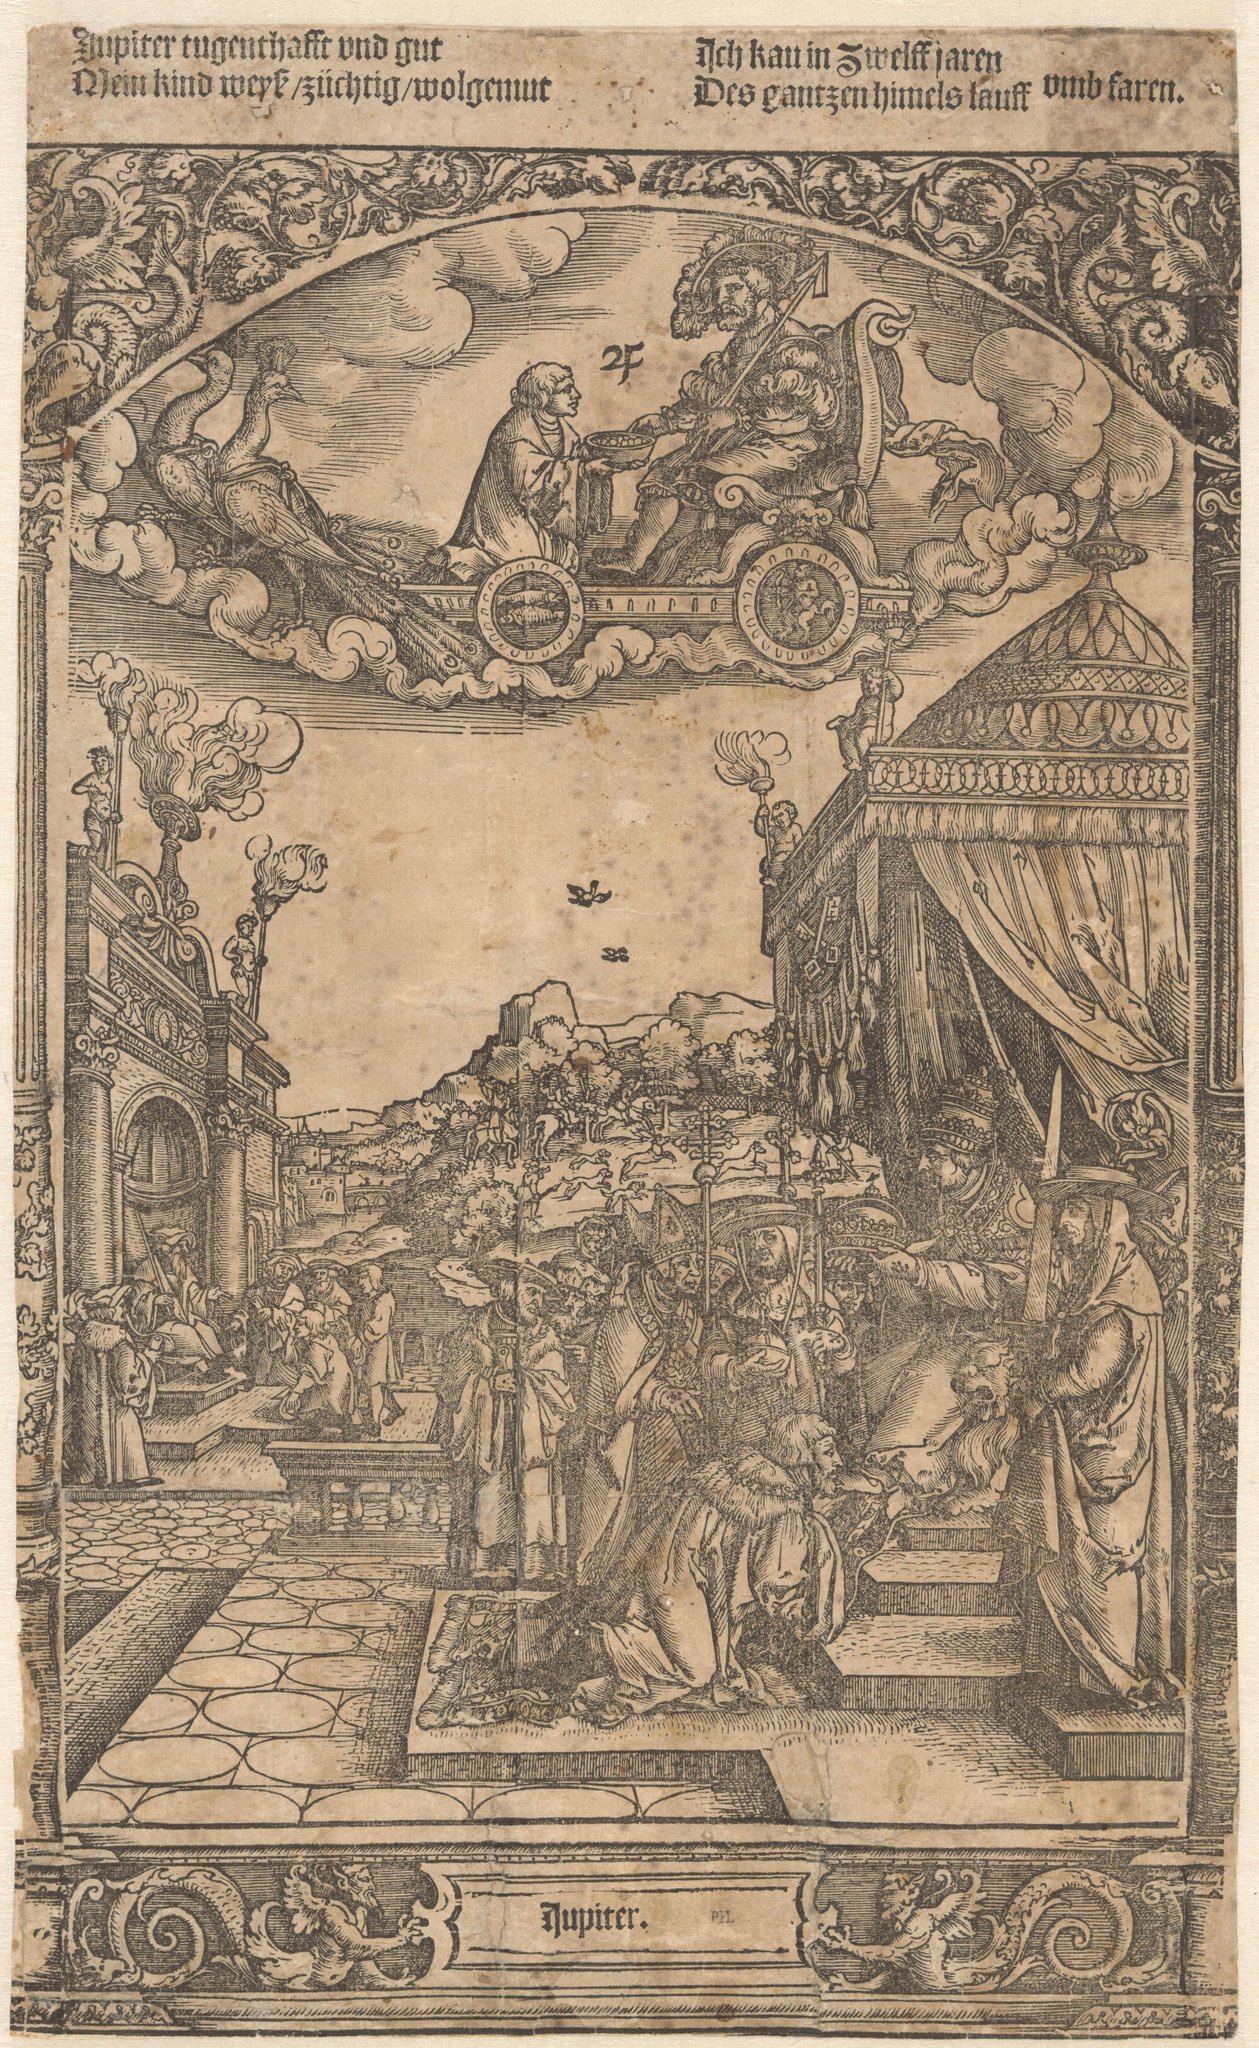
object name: print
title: Jupiter en zijn planeetkinderen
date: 1531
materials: paper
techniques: woodcut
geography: germany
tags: jupiter and his children ('planetenkinder'), jupiter and his children ('planetenkinder') ~ pisces and sagittarius, pisces (zodiacal sign of february), sagittarius (zodiacal sign of november)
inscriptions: collector's mark: Lugt 2228, collector's mark: Lugt 2760, collector's mark: Lugt 2090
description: Jupiter rijdt in zijn triomfwagen aan de hemel, getrokken door twee pauwen. Op de wagen de tekens van de dierenriem Vissen en Boogschutter. De mensen op aarde zijn wereldlijke of kerkelijke machthebbers. Een keizer wordt gekroond door de paus, die is omringd door kardinalen en bisschoppen. Links een rechter op zijn troon. In de achtergrond wordt gejaagd. Bovenaan een vierregelig vers in het Duits.